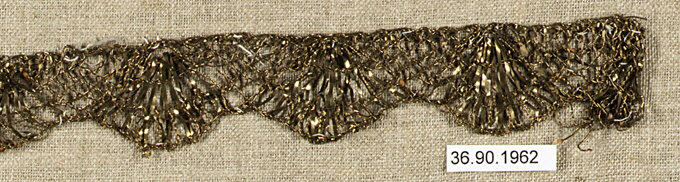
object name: piece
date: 1801-1900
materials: metal thread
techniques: lace